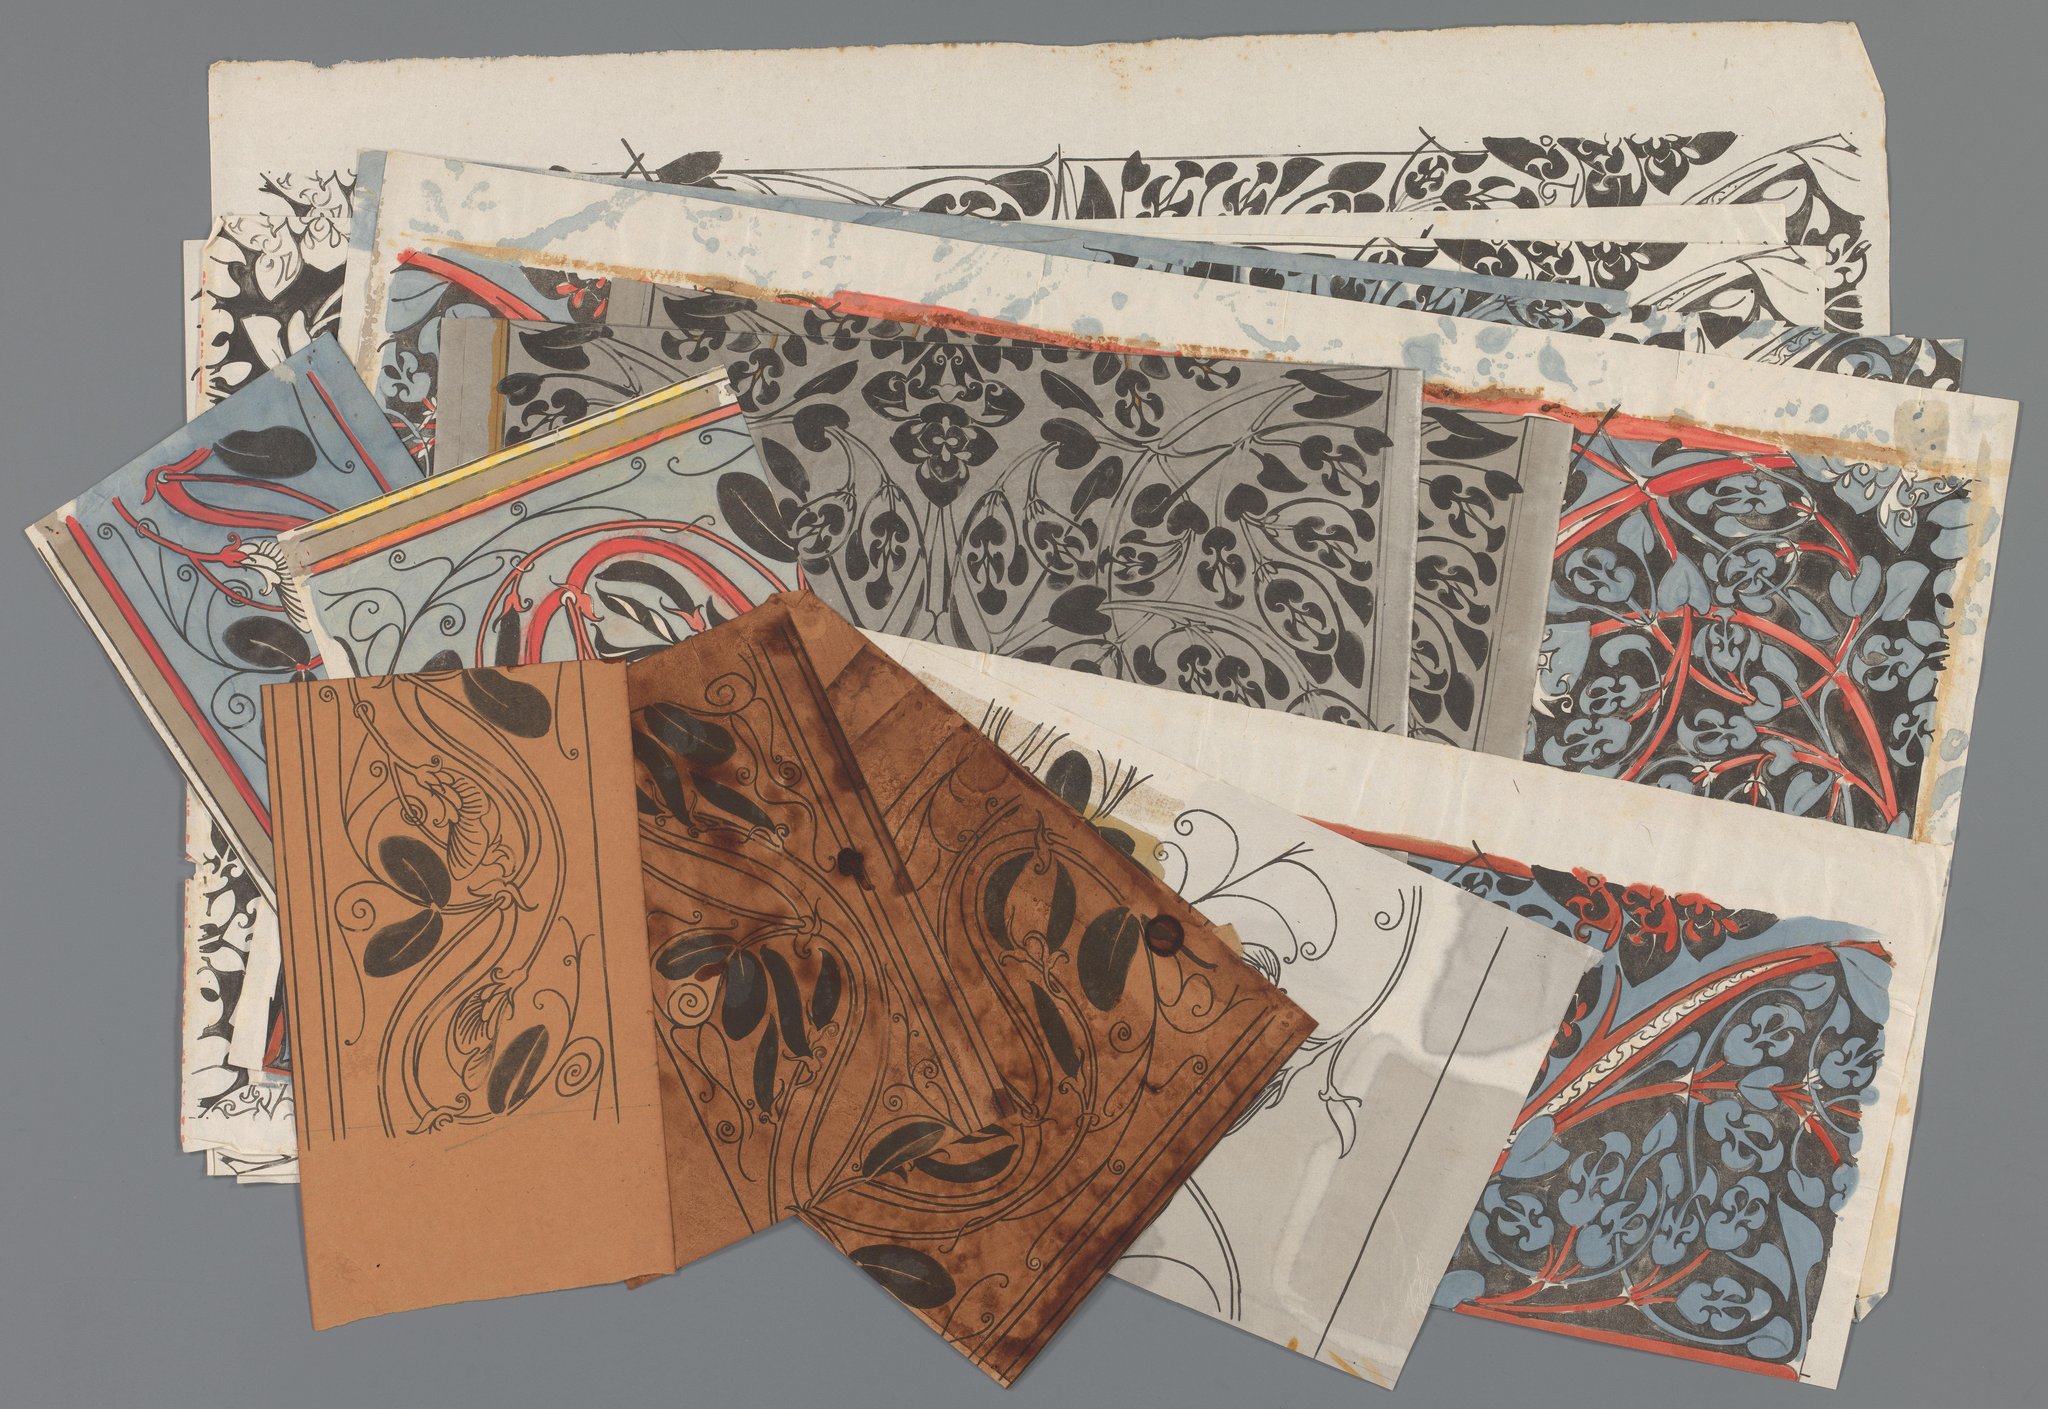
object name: print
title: Bladen behangpapier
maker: gerrit willem dijsselhof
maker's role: designer, draughtsman, print maker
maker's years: 1866-1924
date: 1898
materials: paper, pencil, watercolor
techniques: brush, lithograph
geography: netherlands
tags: wall-paper, flowers: lathyrus, ornament derived from plant forms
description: Groep van 112 bladen papier te gebruiken als behangpapier of papier om meubels mee te beplakken. De groep bestaat uit bladen met twee verschillende ontwerpen. De eerste groep heeft het ontwerp voor een sierstrook of fries met lathyrus motief, ranken, bloemen, bladeren en peulen. Deze groep bevat 11 kleine bladen met ontwerpen gedrukt in zwart en deels met de hand ingekleurd in verschillende kleuren. Naast deze kleinere fragmenten zijn er ook hele 67 complete bladen met 6 onderdelen van de fries op één blad gedrukt en gemaakt om uit te knippen. De tweede groep heeft een bladvullend ontwerp 'Tuinboon', met hartvormige bladeren en bloemen. De gehele bladen kunnen passend aan elkaar gemonteerd worden. Hiervan zijn 8 delen van bladen gedrukt in zwart en geheel of deels gekleurd in grijs, blauw en rood. De overige 26 complete bladen zijn niet ingekleurd.